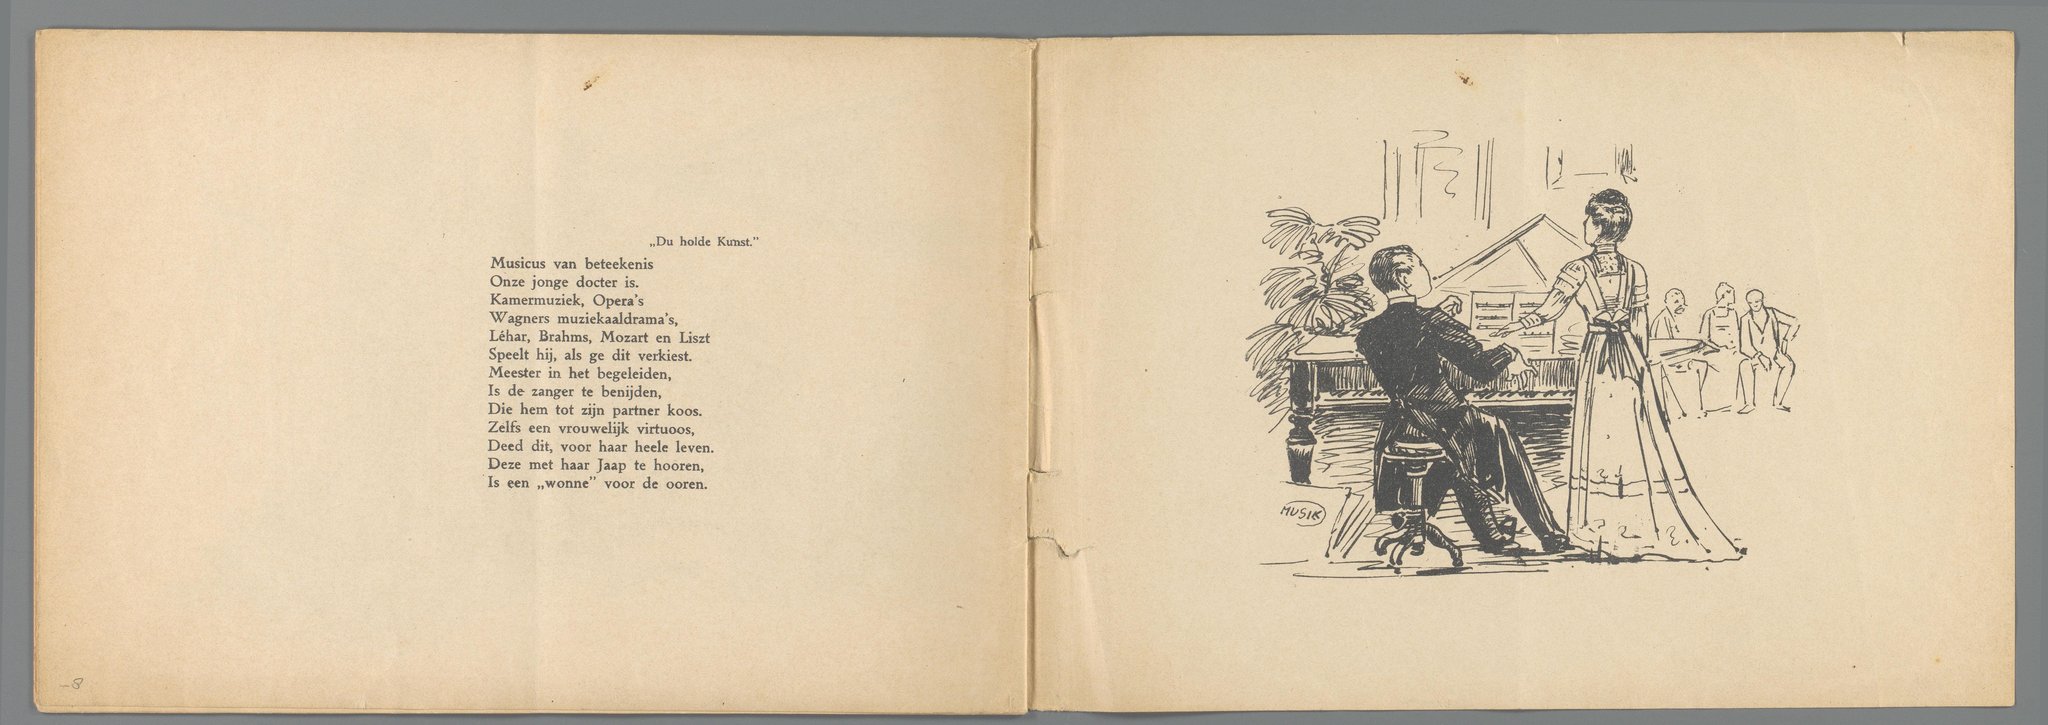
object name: print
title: Jakob Gijsbert de Hoop Scheffer speelt piano met een zangeres aan zijn zijde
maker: Anonymous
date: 1910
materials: paper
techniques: lithograph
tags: grand piano, vocal music, singing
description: Bij gebrek aan gegevens over de vervaardiger is voor de bepaling van de rechten van dit object gebruik gemaakt van de vervaardigingsdatum.